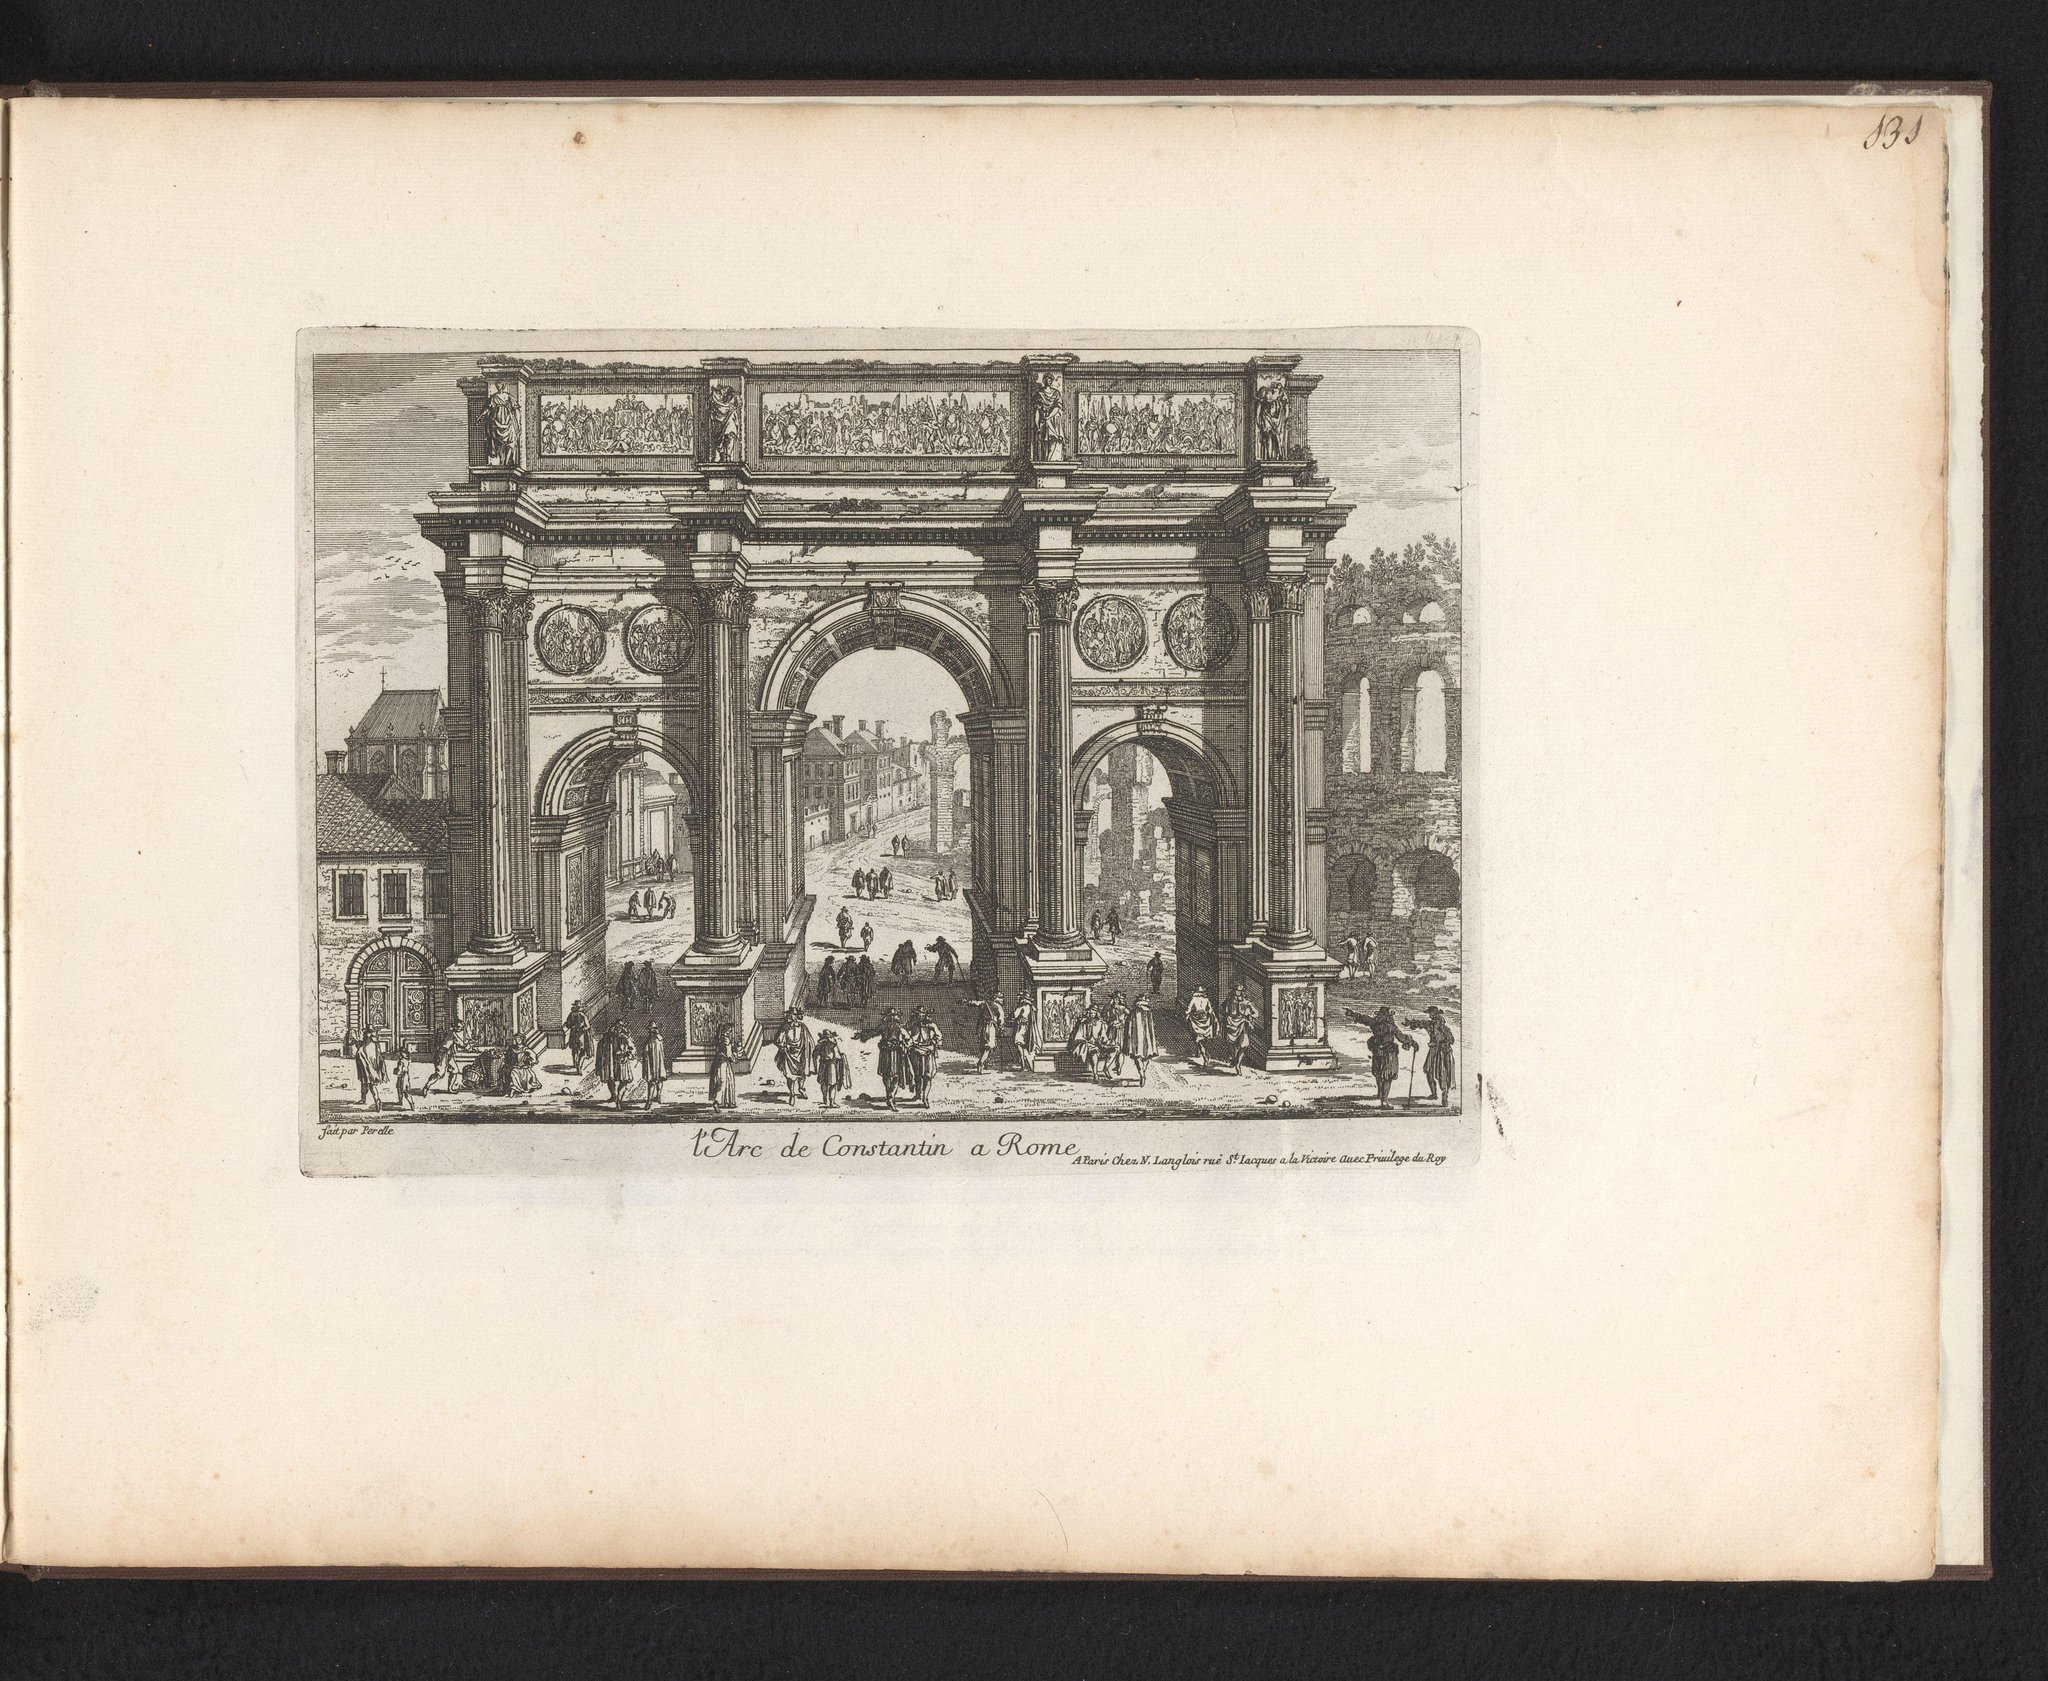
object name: print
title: Gezicht op de boog van Constantijn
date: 1650-1695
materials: paper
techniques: etching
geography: paris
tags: triumphal arch, arch of constantine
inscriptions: collector's mark: Lugt 2228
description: Prenten met het signatuur 'Perelle' kunnen zowel door vader Gabriel als door zonen Nicolas en Adam gemaakt zijn. De uitgevers vader en zoon Nicolas Langlois worden allebei vermeld als N. Langlois op hetzelfde adres.